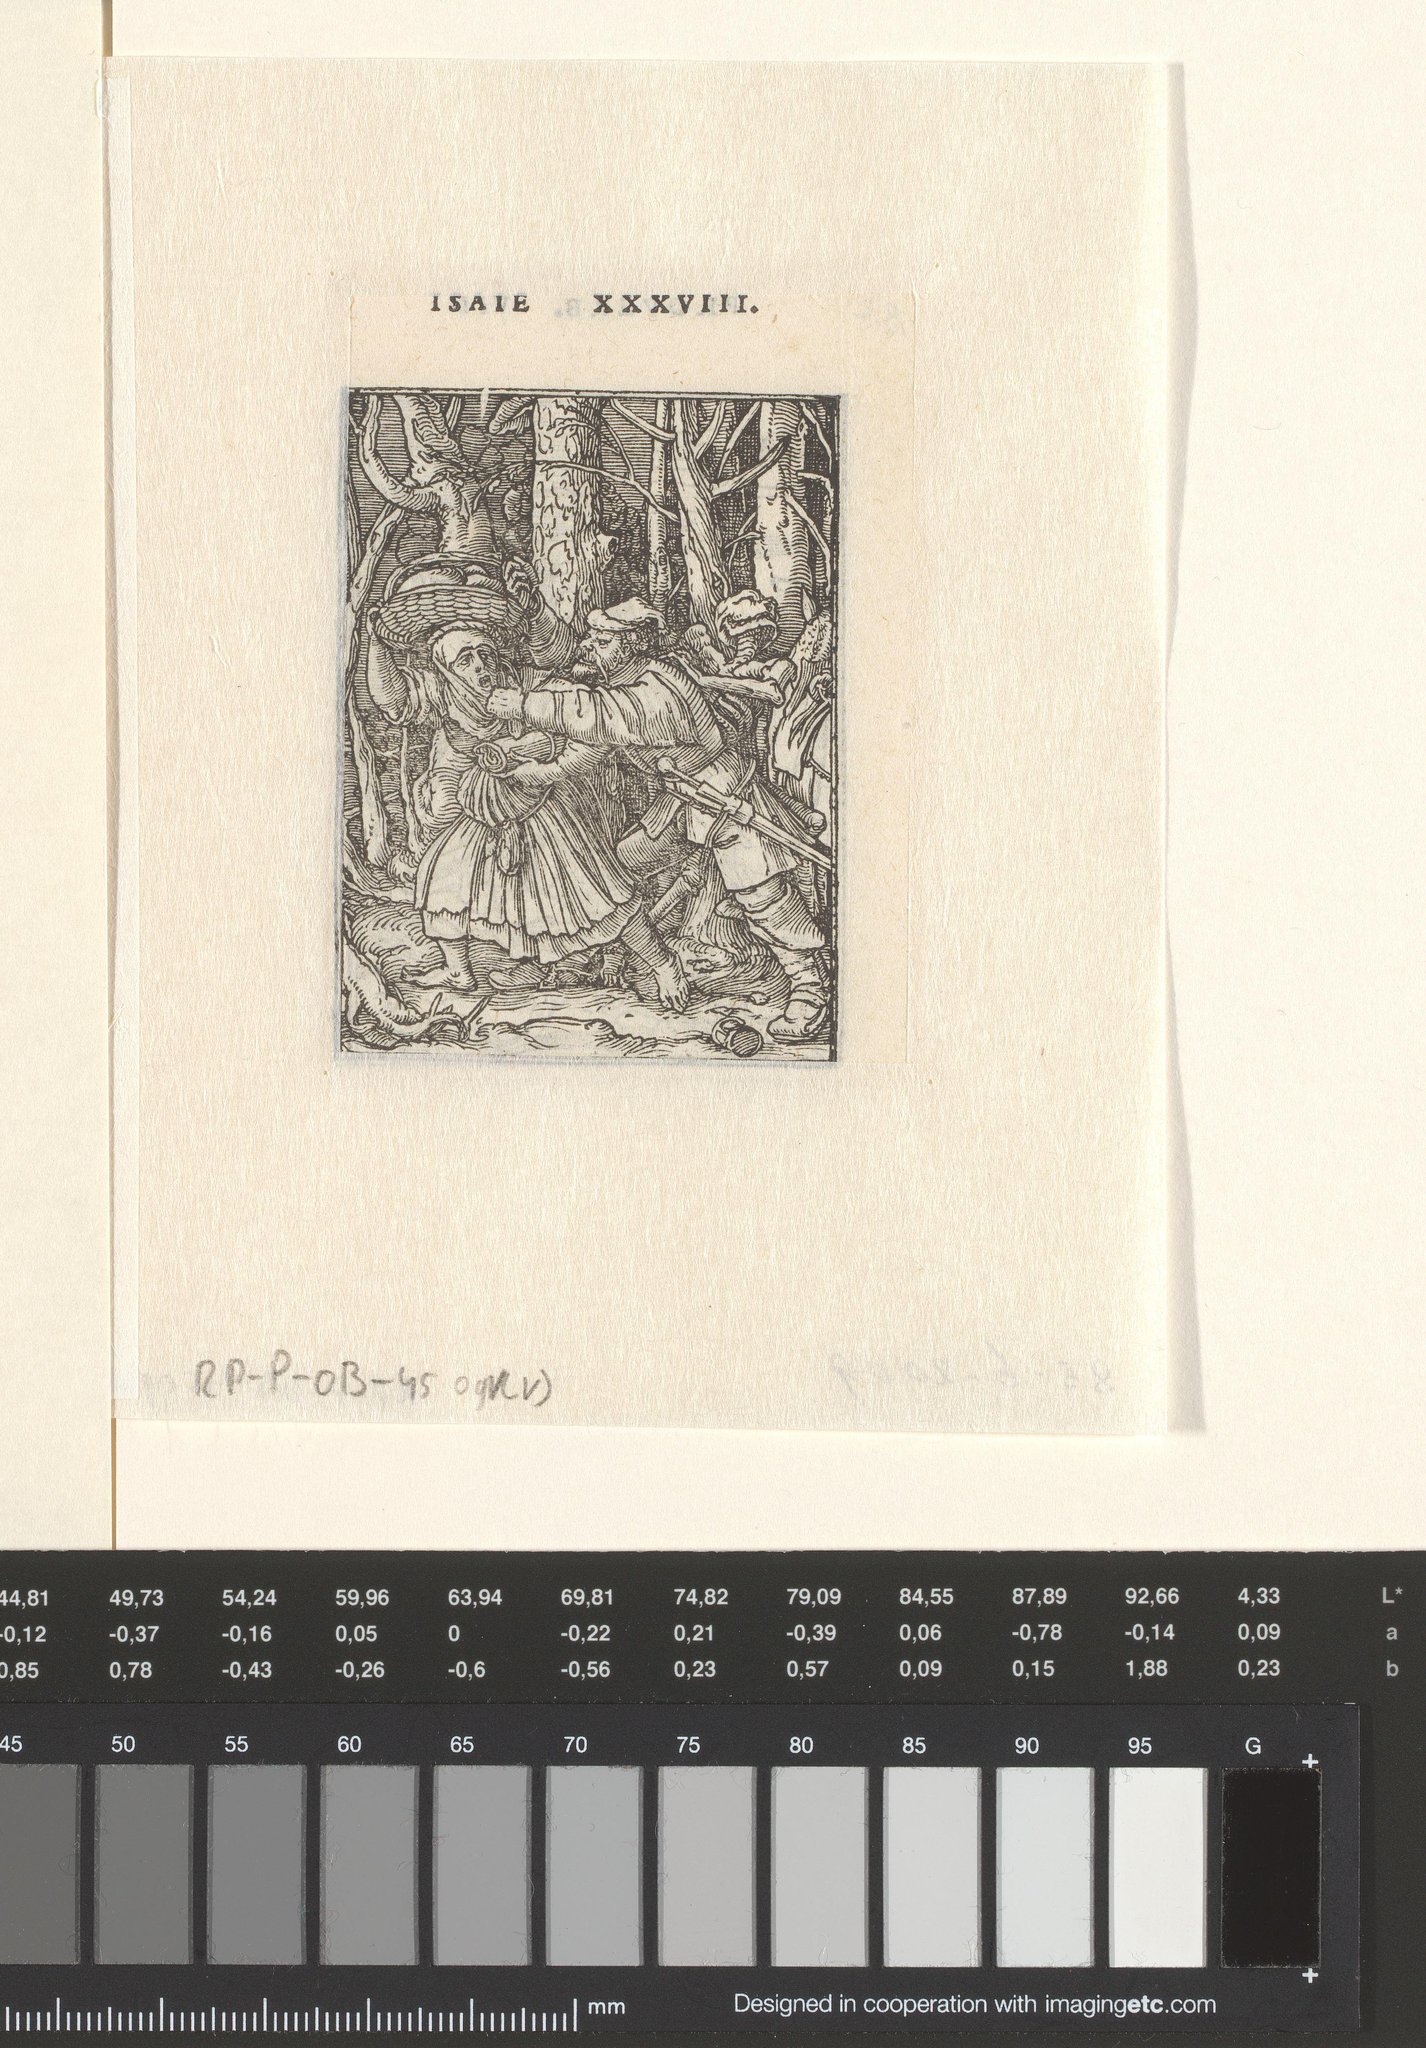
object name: print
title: Dodendans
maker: hans holbein (der jüngere)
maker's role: draughtsman, painter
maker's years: 1497-1543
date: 1547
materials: paper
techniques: woodcut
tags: dance of death; death together with one or more human beings, traveller(s) attacked by robber(s), robber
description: De serie boekillustraties bekend onder de titel Dodendans werden in 1547 aangevuld met twaalf houtsneden die voor het eerst verschenen in: Imagines Mortis duodecim Imaginibus praeter priores ... à Georgio Aemylio translata, cumulatae ..., Lyon 1547, J. en F. Frellon. Later verschenen nog andere uitgaven.